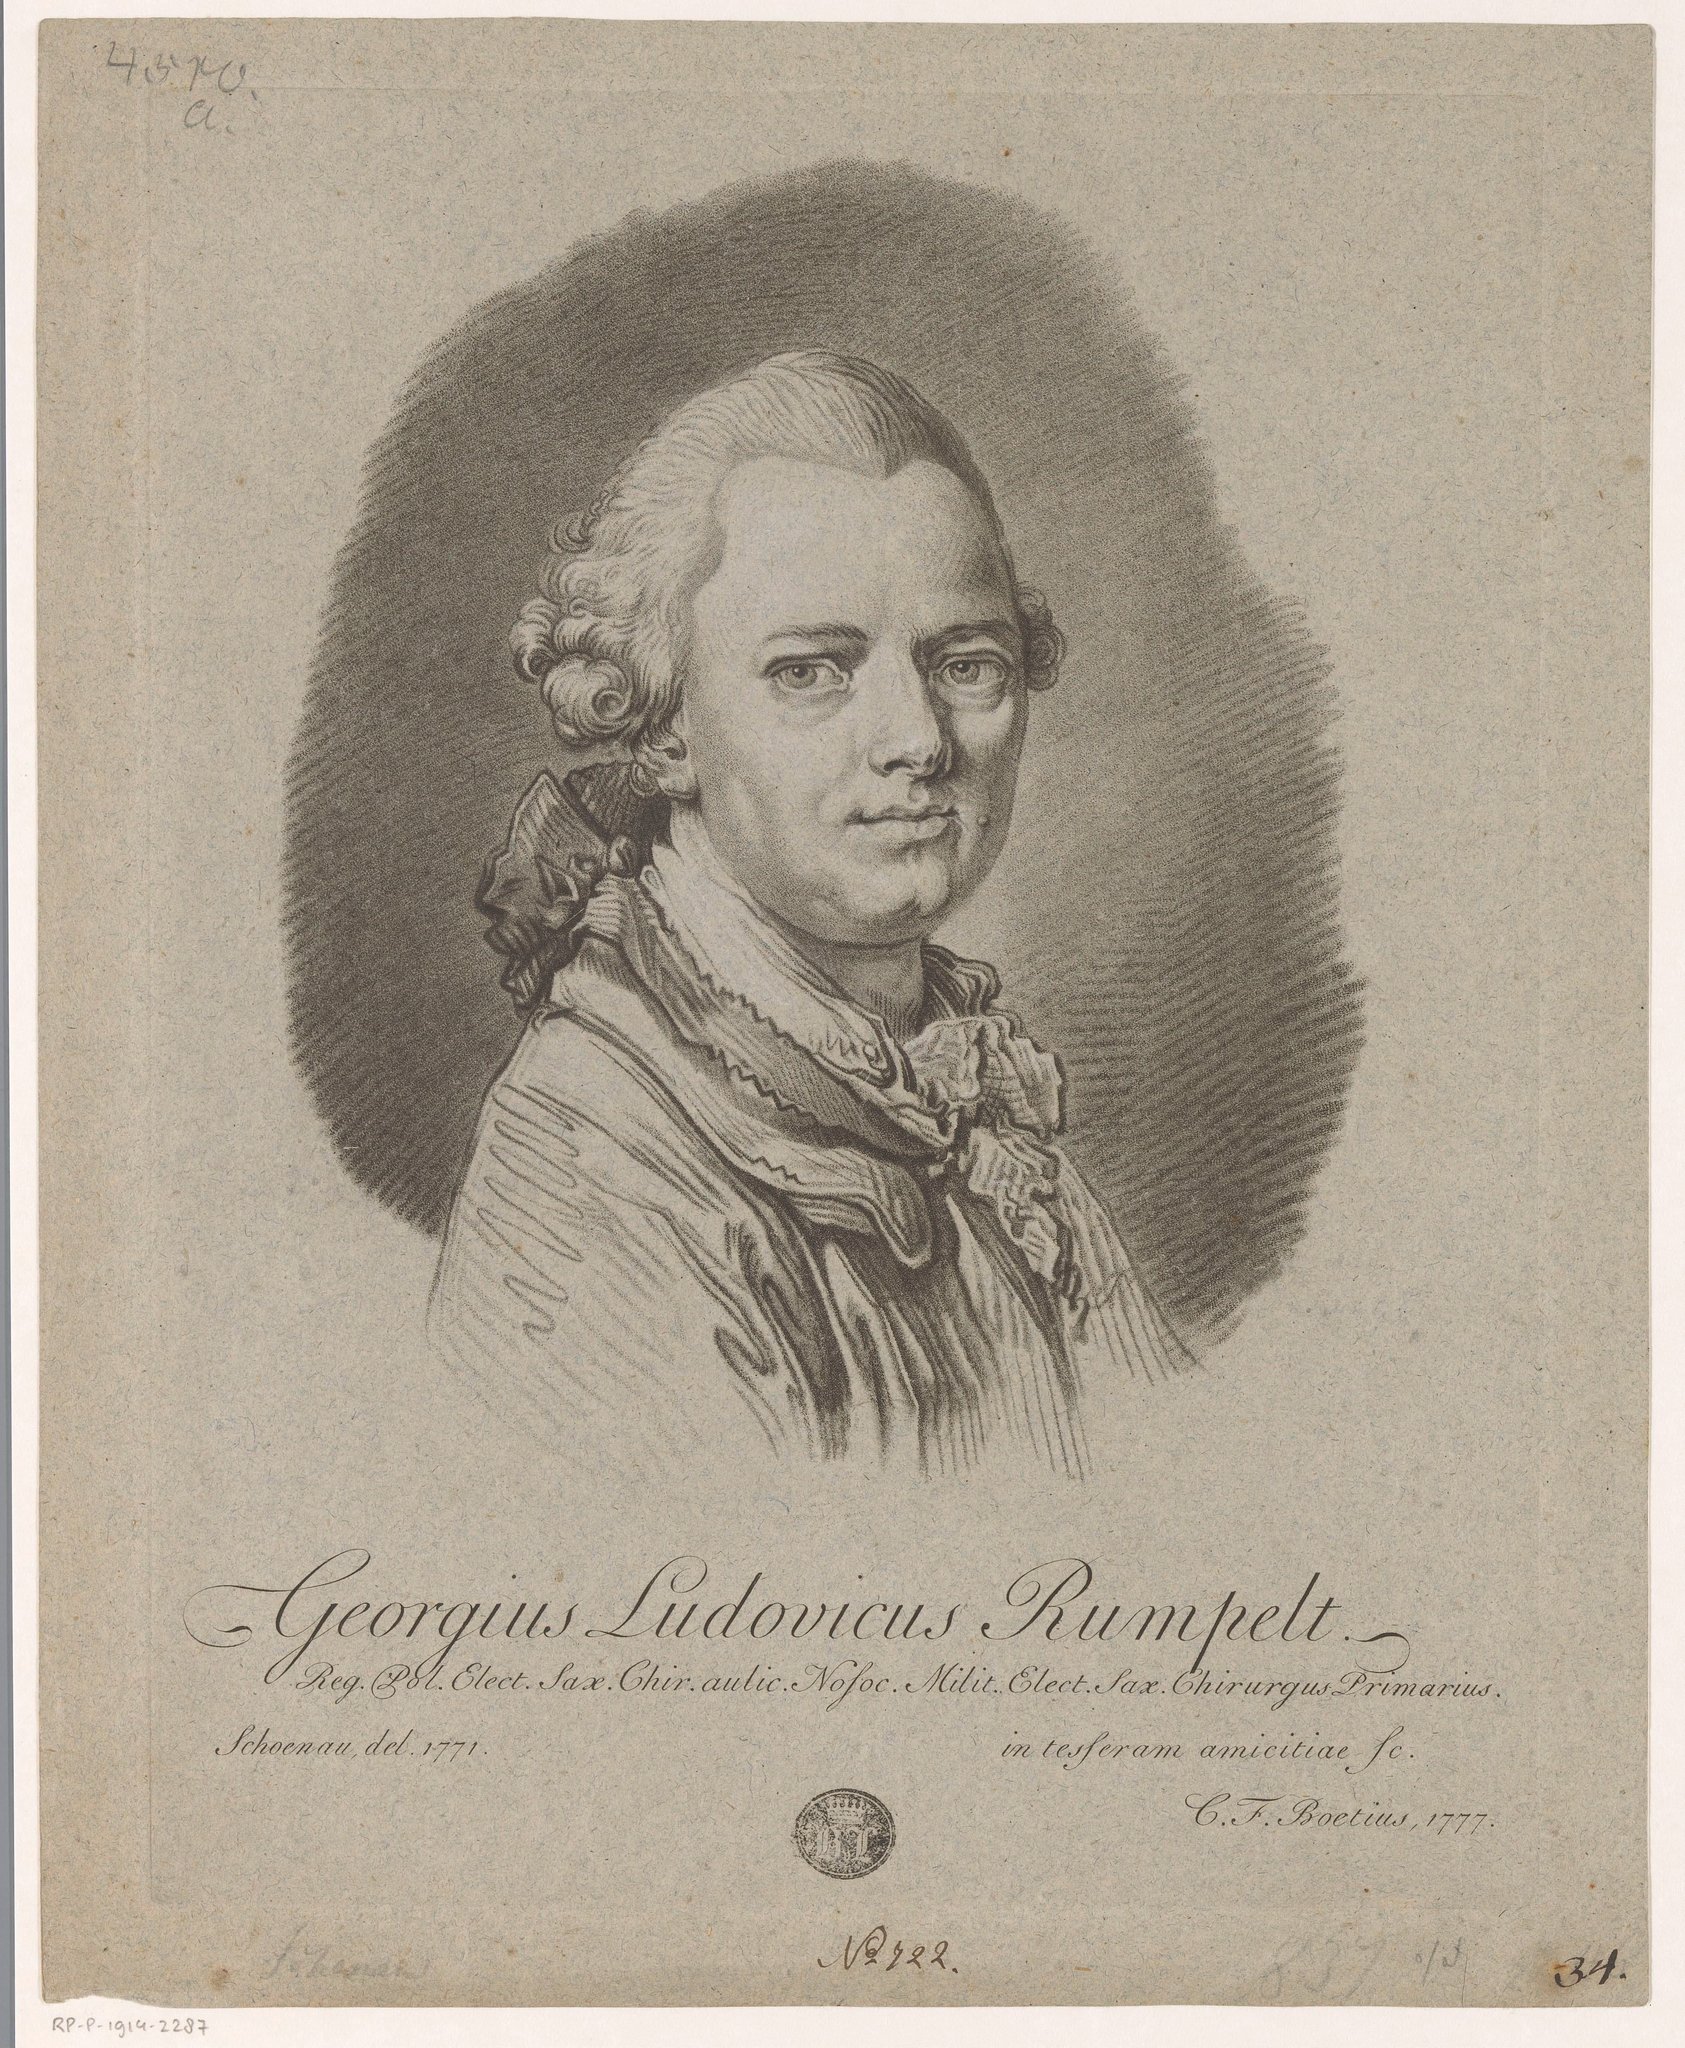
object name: print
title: Portret van Georg Ludwig Rumpelt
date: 1777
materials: paper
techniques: printmaking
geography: dresden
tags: georg ludwig rumpelt, historical persons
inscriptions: collector's mark: Lugt 2228, collector's mark: Lugt 417